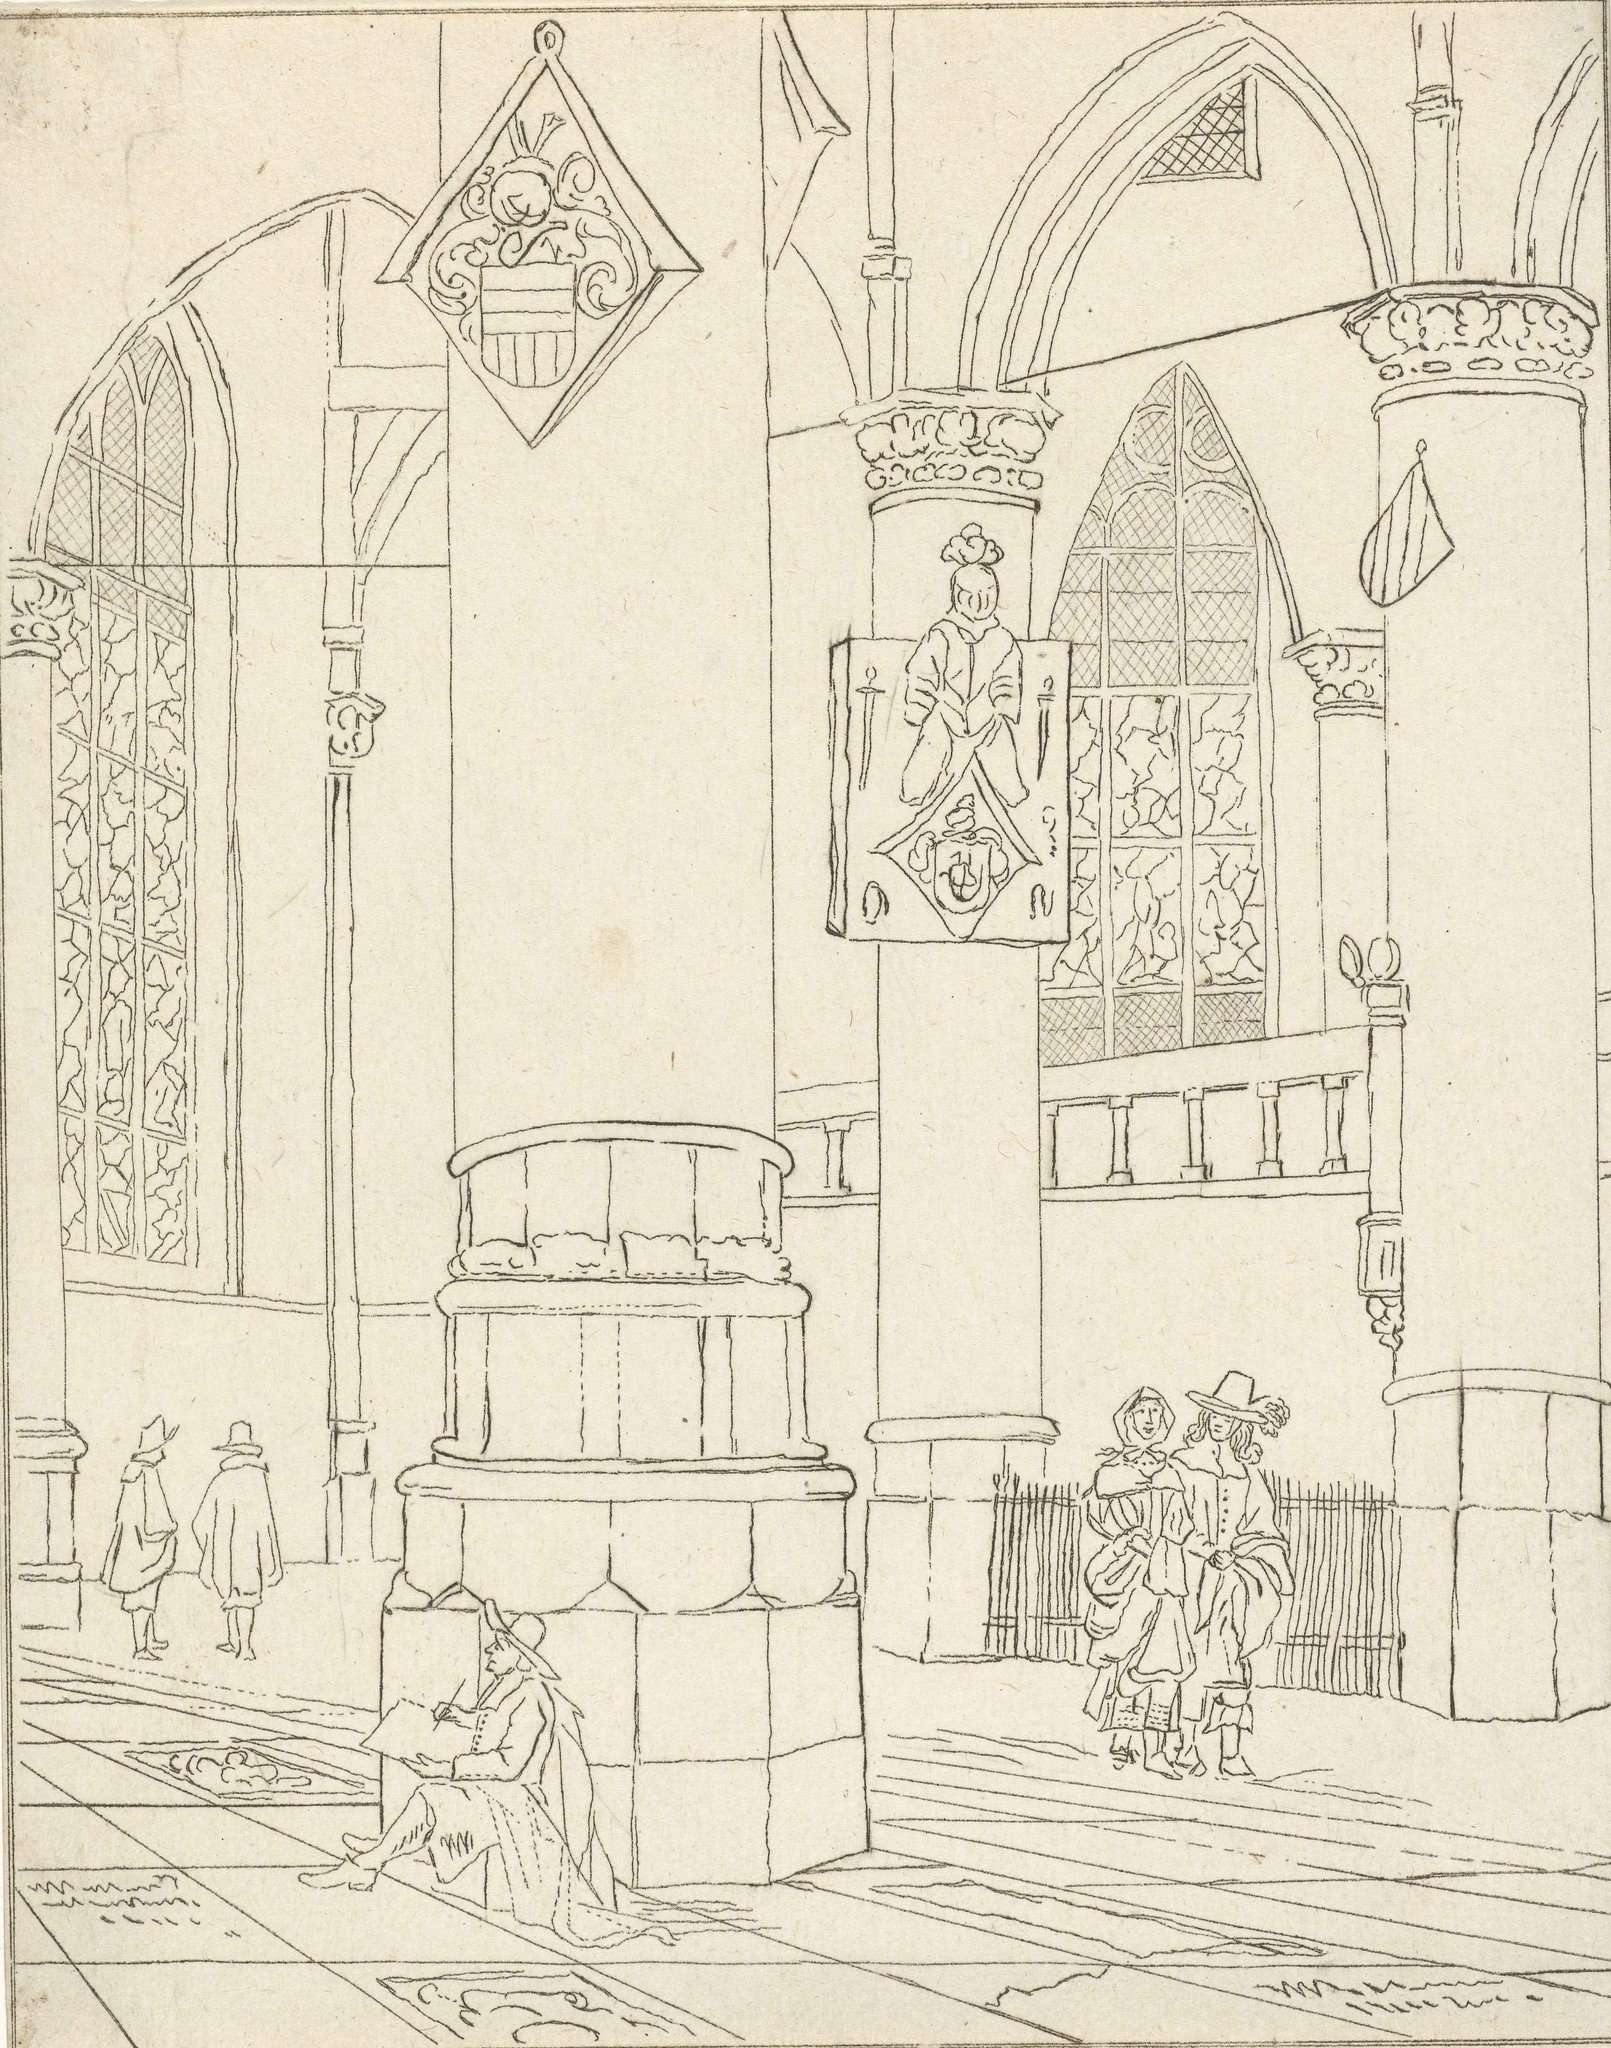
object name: print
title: Kerkinterieur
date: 1774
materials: paper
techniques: etching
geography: amsterdam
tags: interior of church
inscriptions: collector's mark: Lugt 240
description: Interieur van een kerk. Aan de voet van een pilaar zit een kunstenaar te tekenen. Rechts lopen een gearmde man en een vrouw.